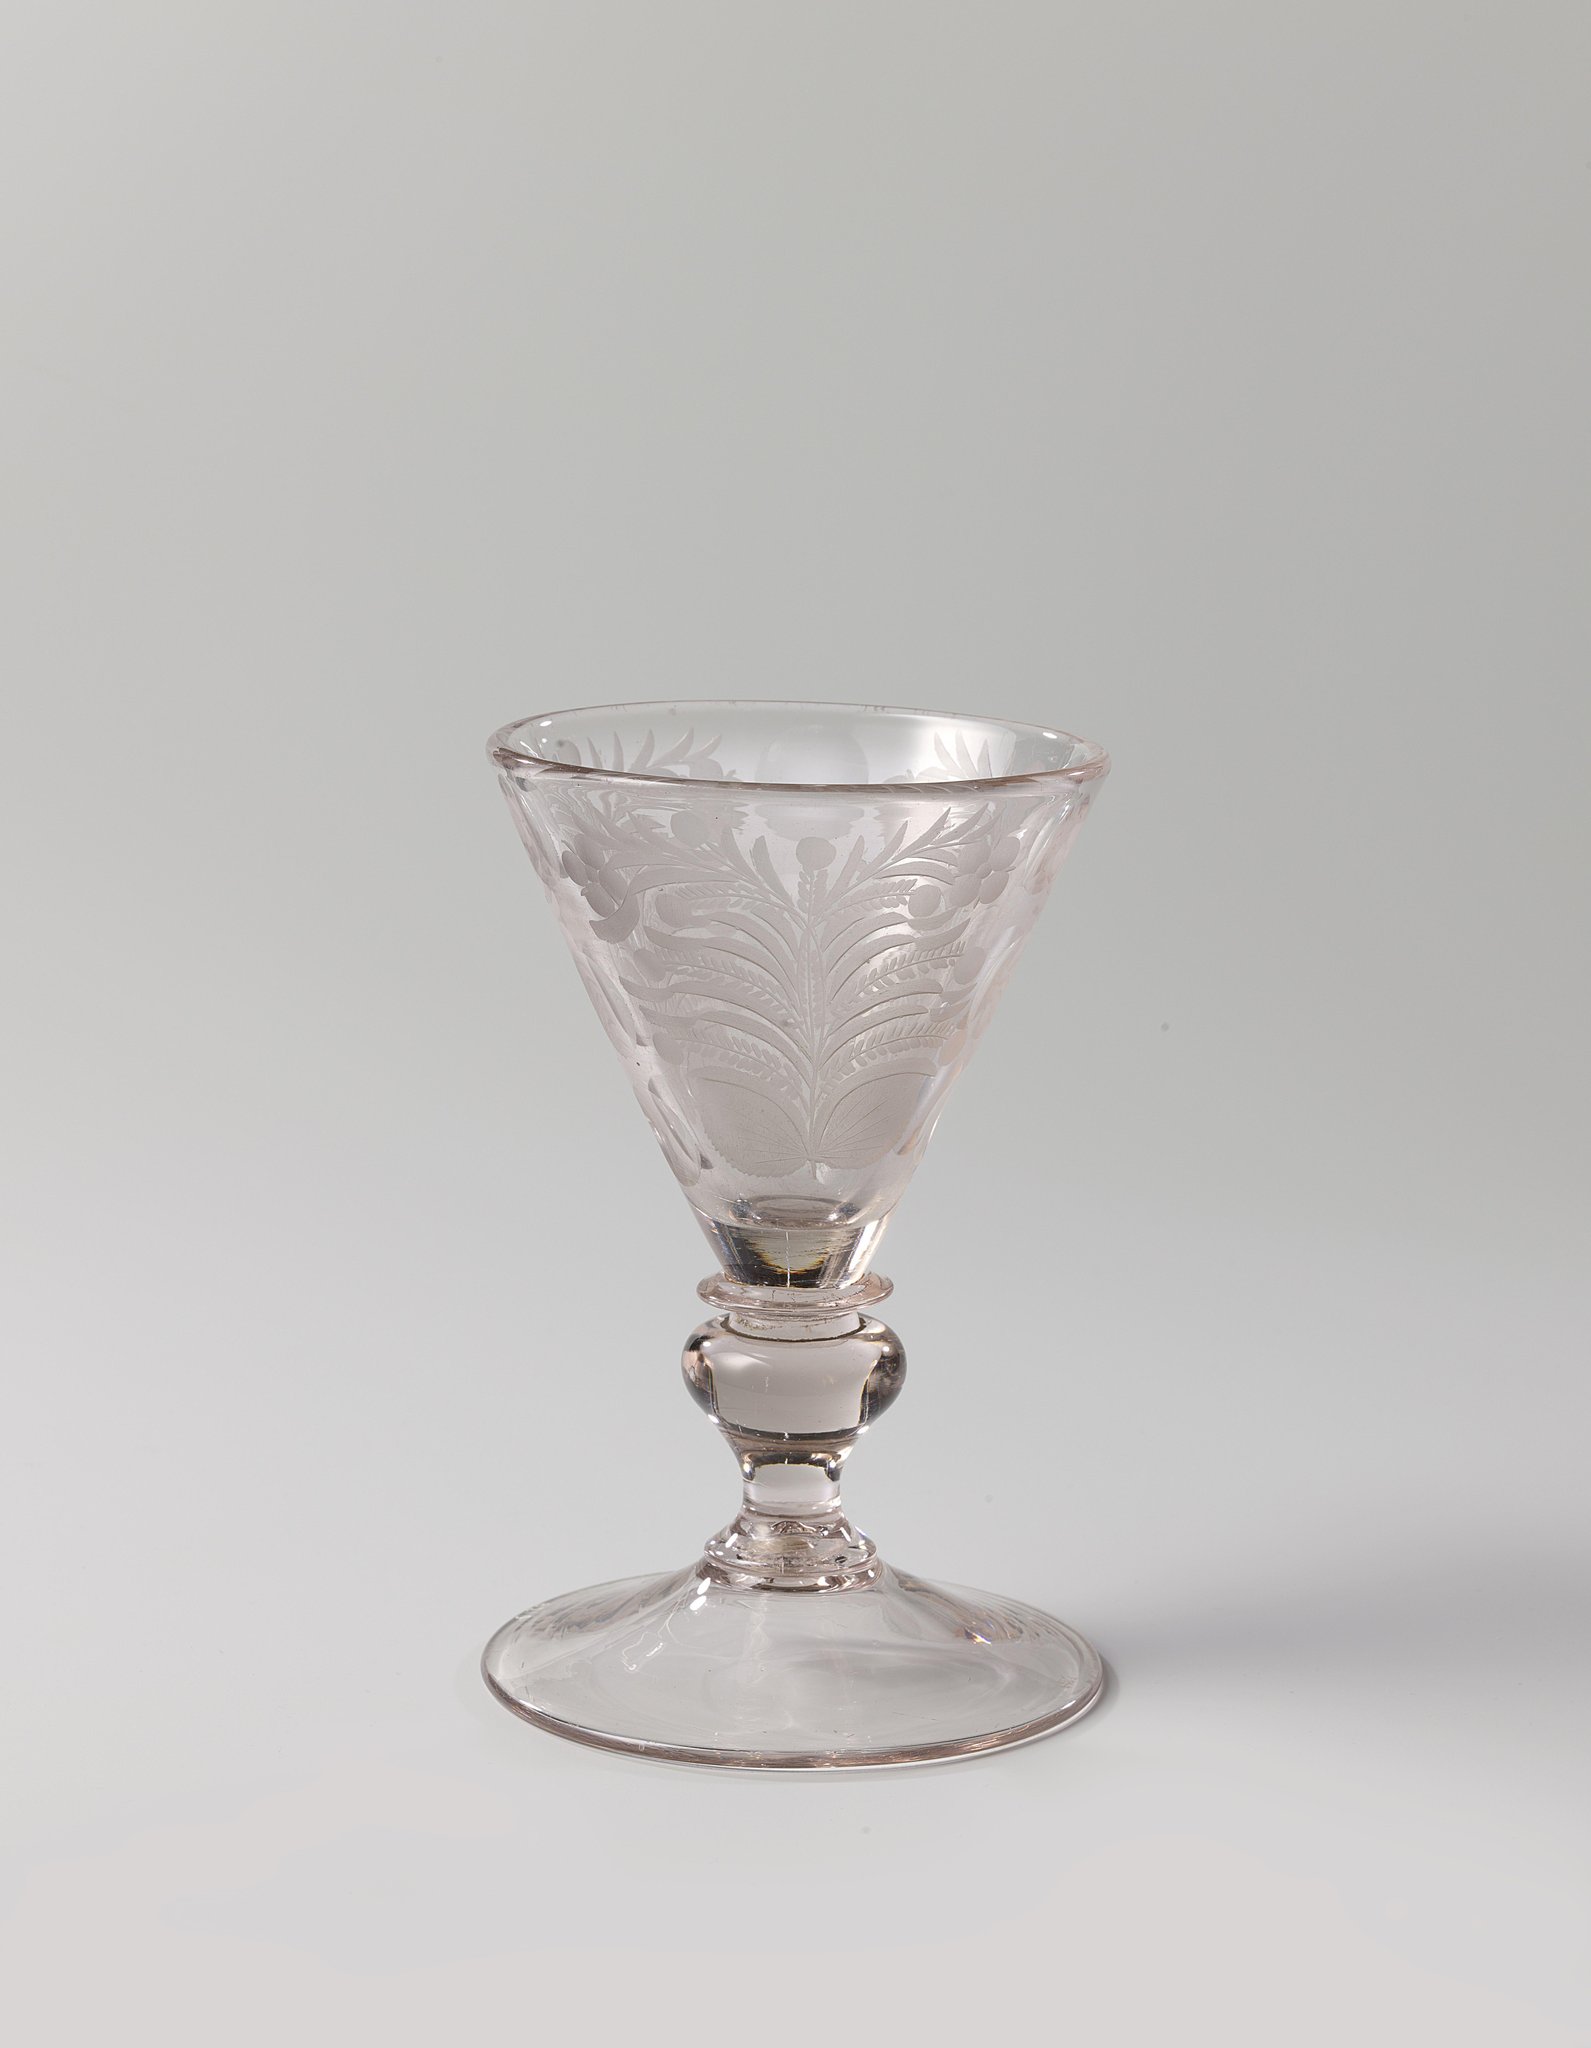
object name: goblet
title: Kelkglas met bladranken en cirkels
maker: Anonymous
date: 1700-1725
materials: glass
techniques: glassblowing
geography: bohemia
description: Kelkglas van helder, kleurloos glas. Op de kelk gegraveerde bladranken en cirkels.